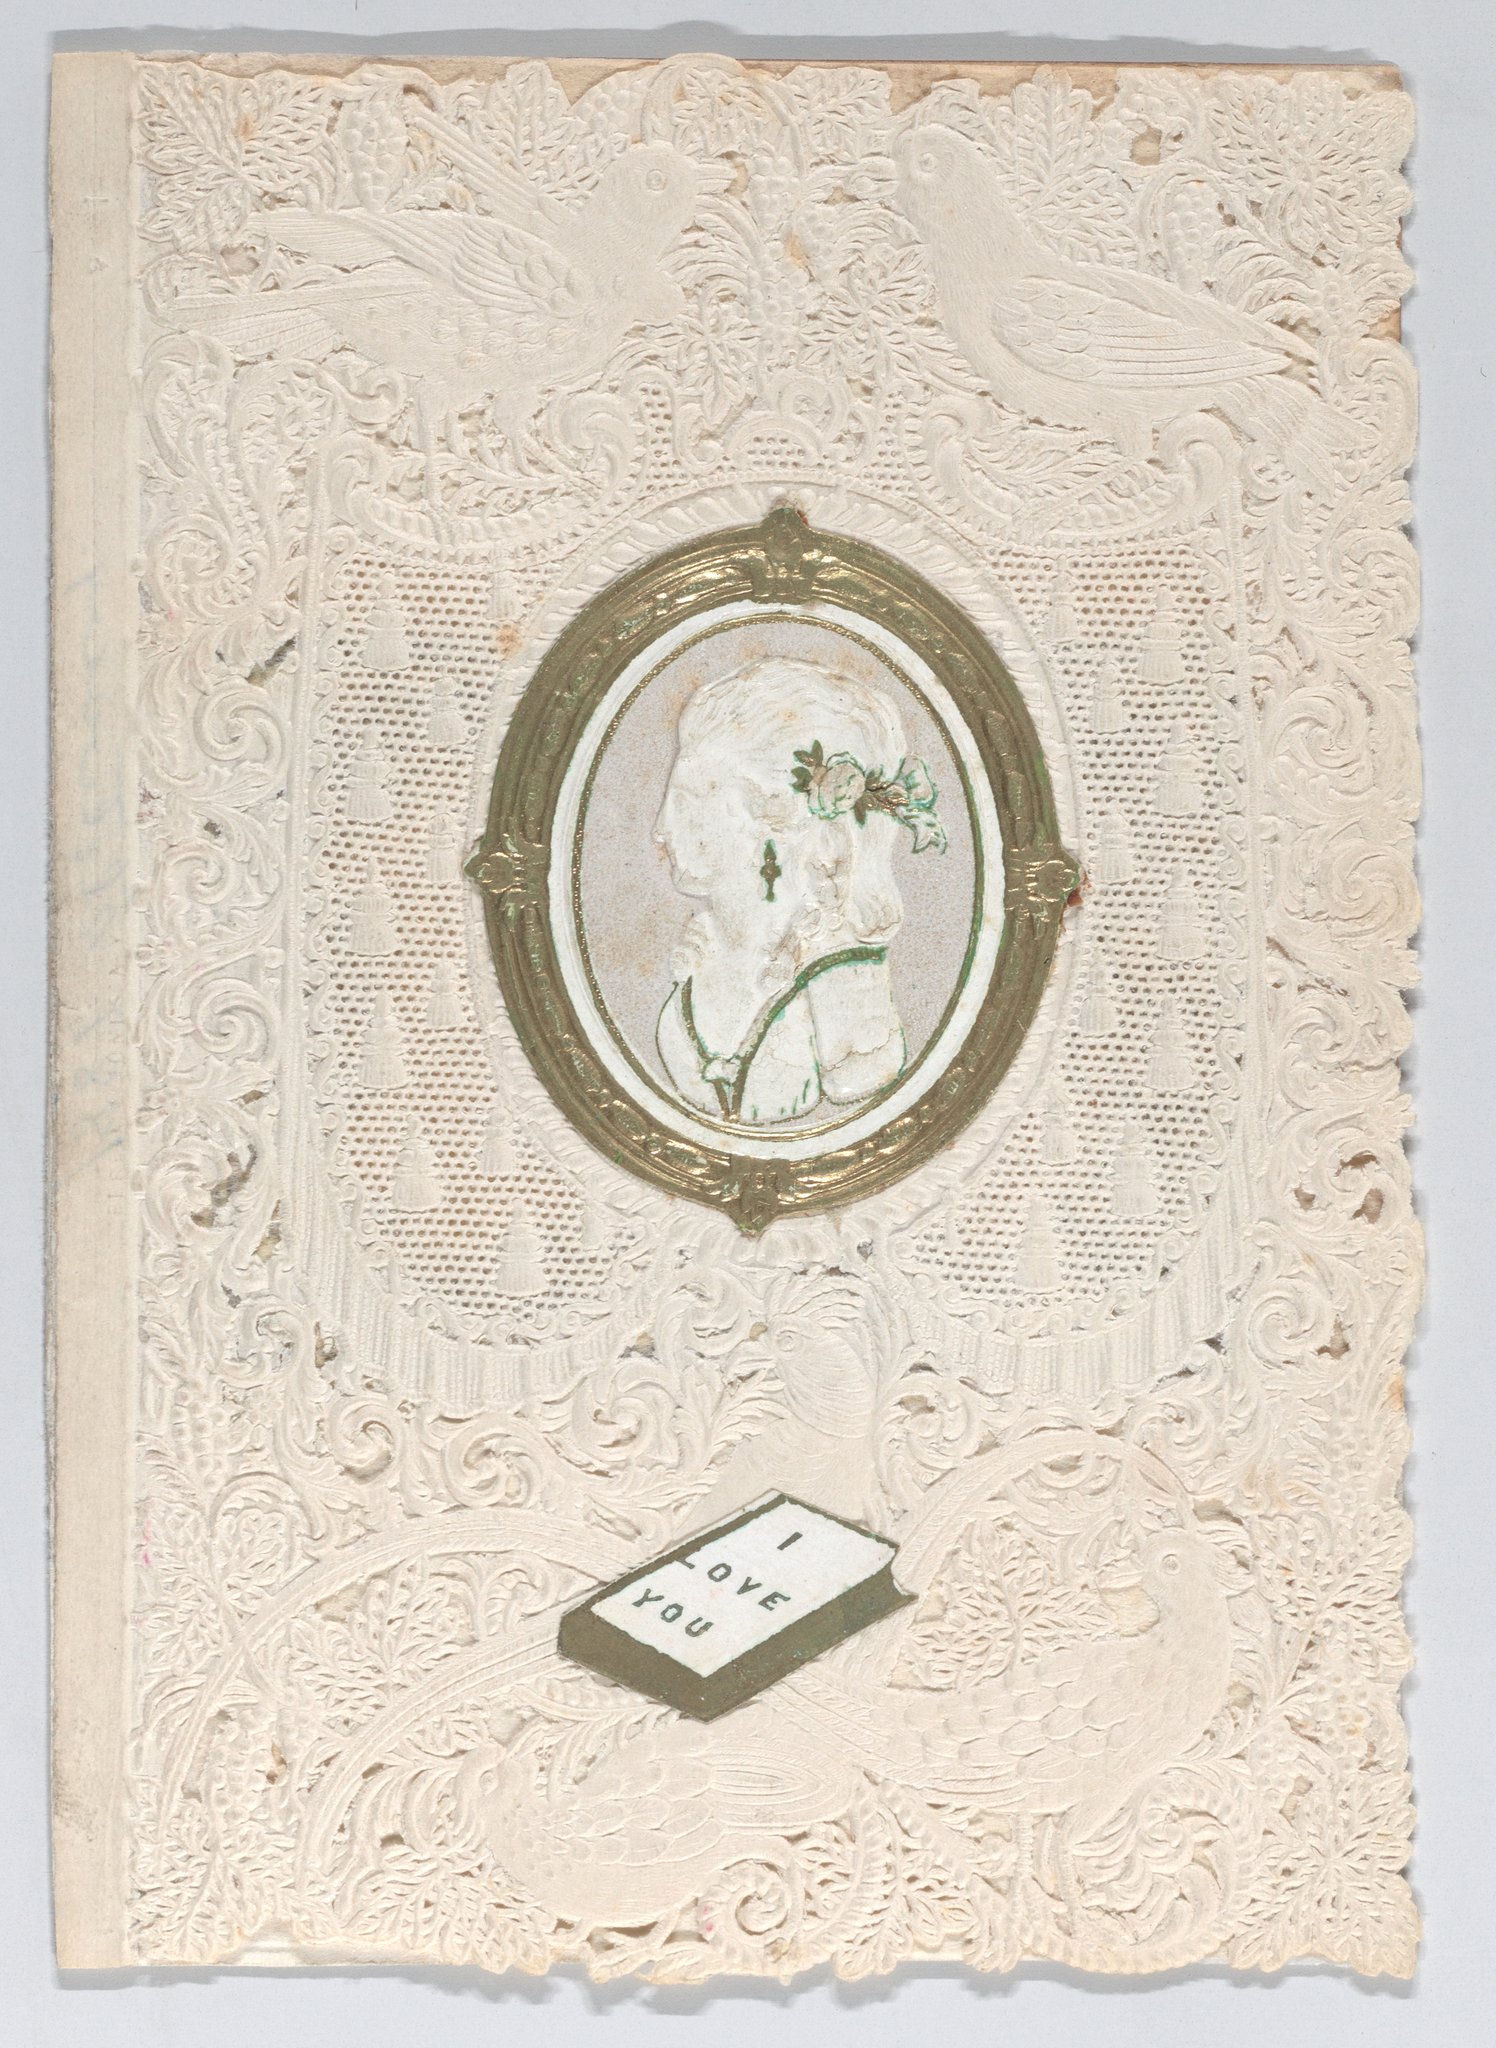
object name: valentine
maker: Anonymous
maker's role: artist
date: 1859-1869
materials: lace, paper, watercolor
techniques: embossing, lithograph, open work